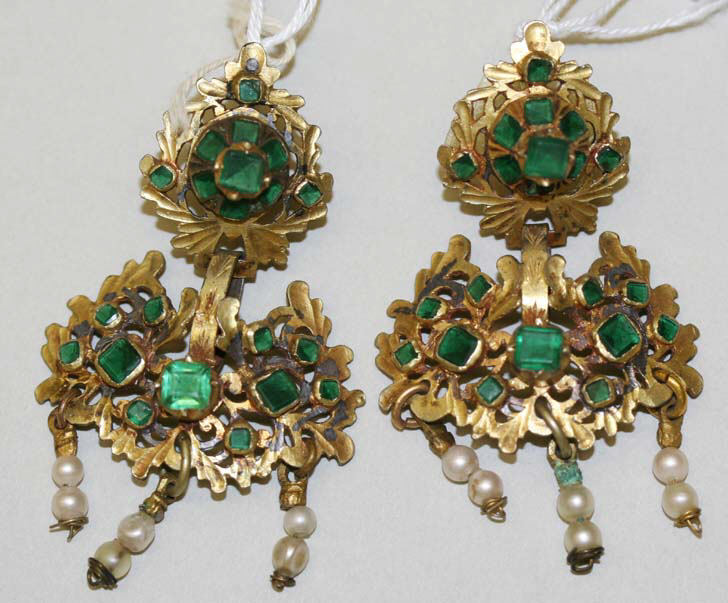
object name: earring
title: Earrings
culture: spanish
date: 1801-1900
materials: metal, pearl